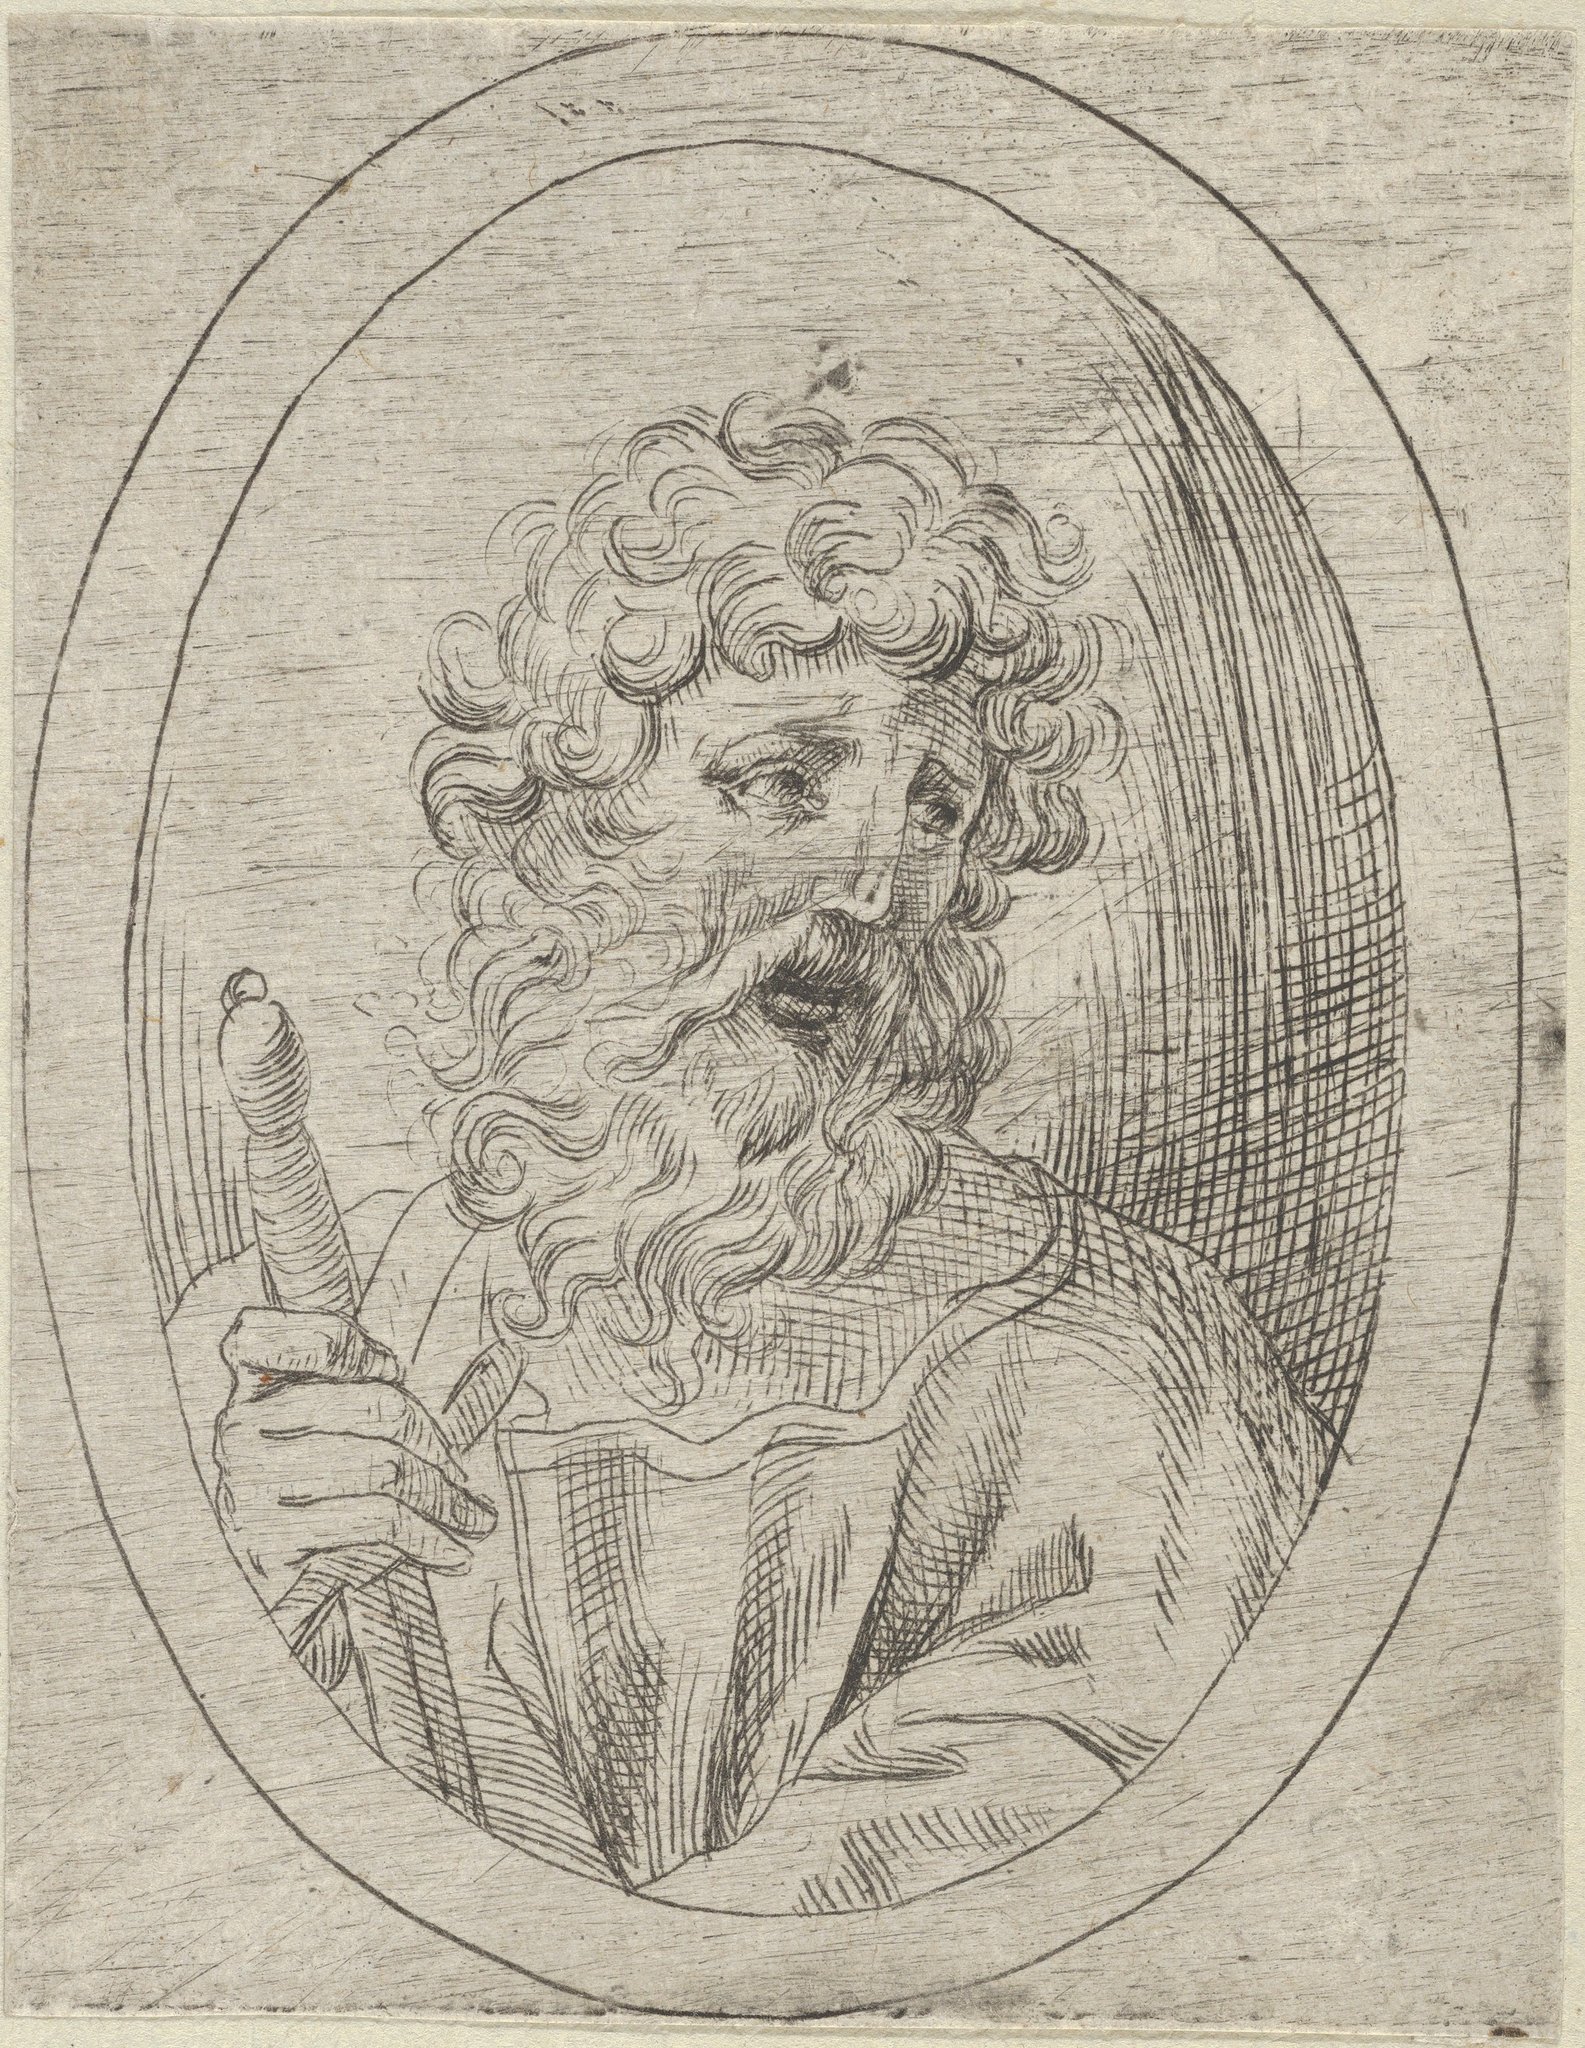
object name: print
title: Saint Paul holding a sword, in an oval frame, from "Christ, the Virgin, and Thirteen Apostles"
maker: anonymous, 17th century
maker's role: artist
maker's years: 1600-1700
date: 1600-1640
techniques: etching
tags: swords,portraits,saint paul